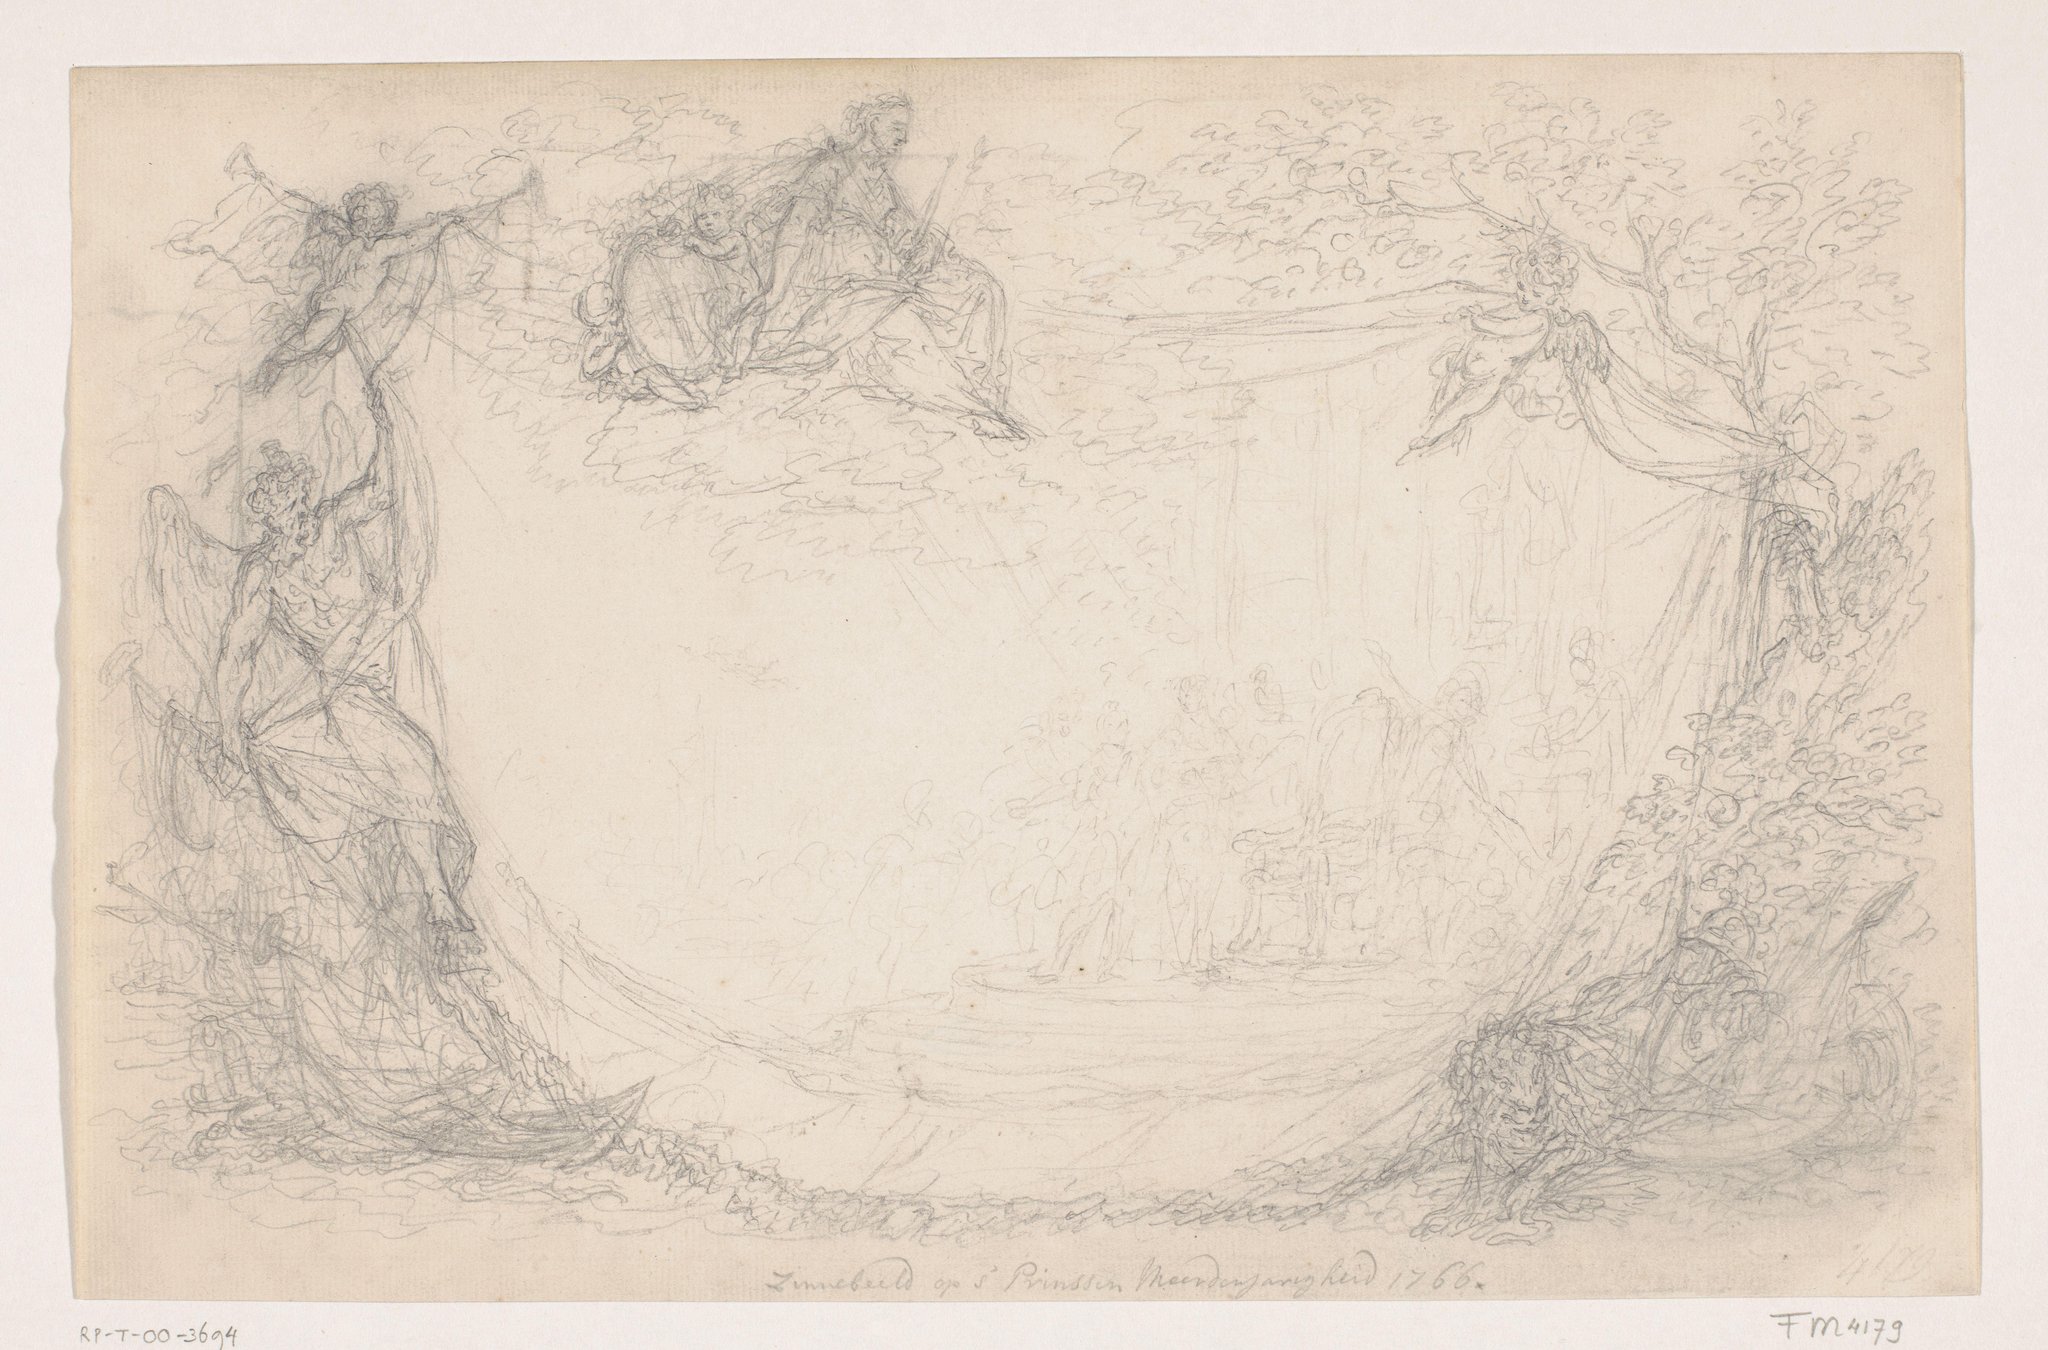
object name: drawing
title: Zinnebeeld op 's Prinssen Meerderjarigheid 1766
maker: reinier vinkeles (i)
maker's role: draughtsman, print maker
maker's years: 1741-1816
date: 1766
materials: paper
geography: northern netherlands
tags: the hague, william v (prince of orange)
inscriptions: collector's mark: Lugt 2228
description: Allegorie op de meerderjarigheid van prins Willem V op achttienjarige leeftijd op 8 maart 1766. Onvoltooid ontwerp voor een niet uitgevoerde prent met een omlijsting met allegorische figuren. Ontwerp voor een prent.